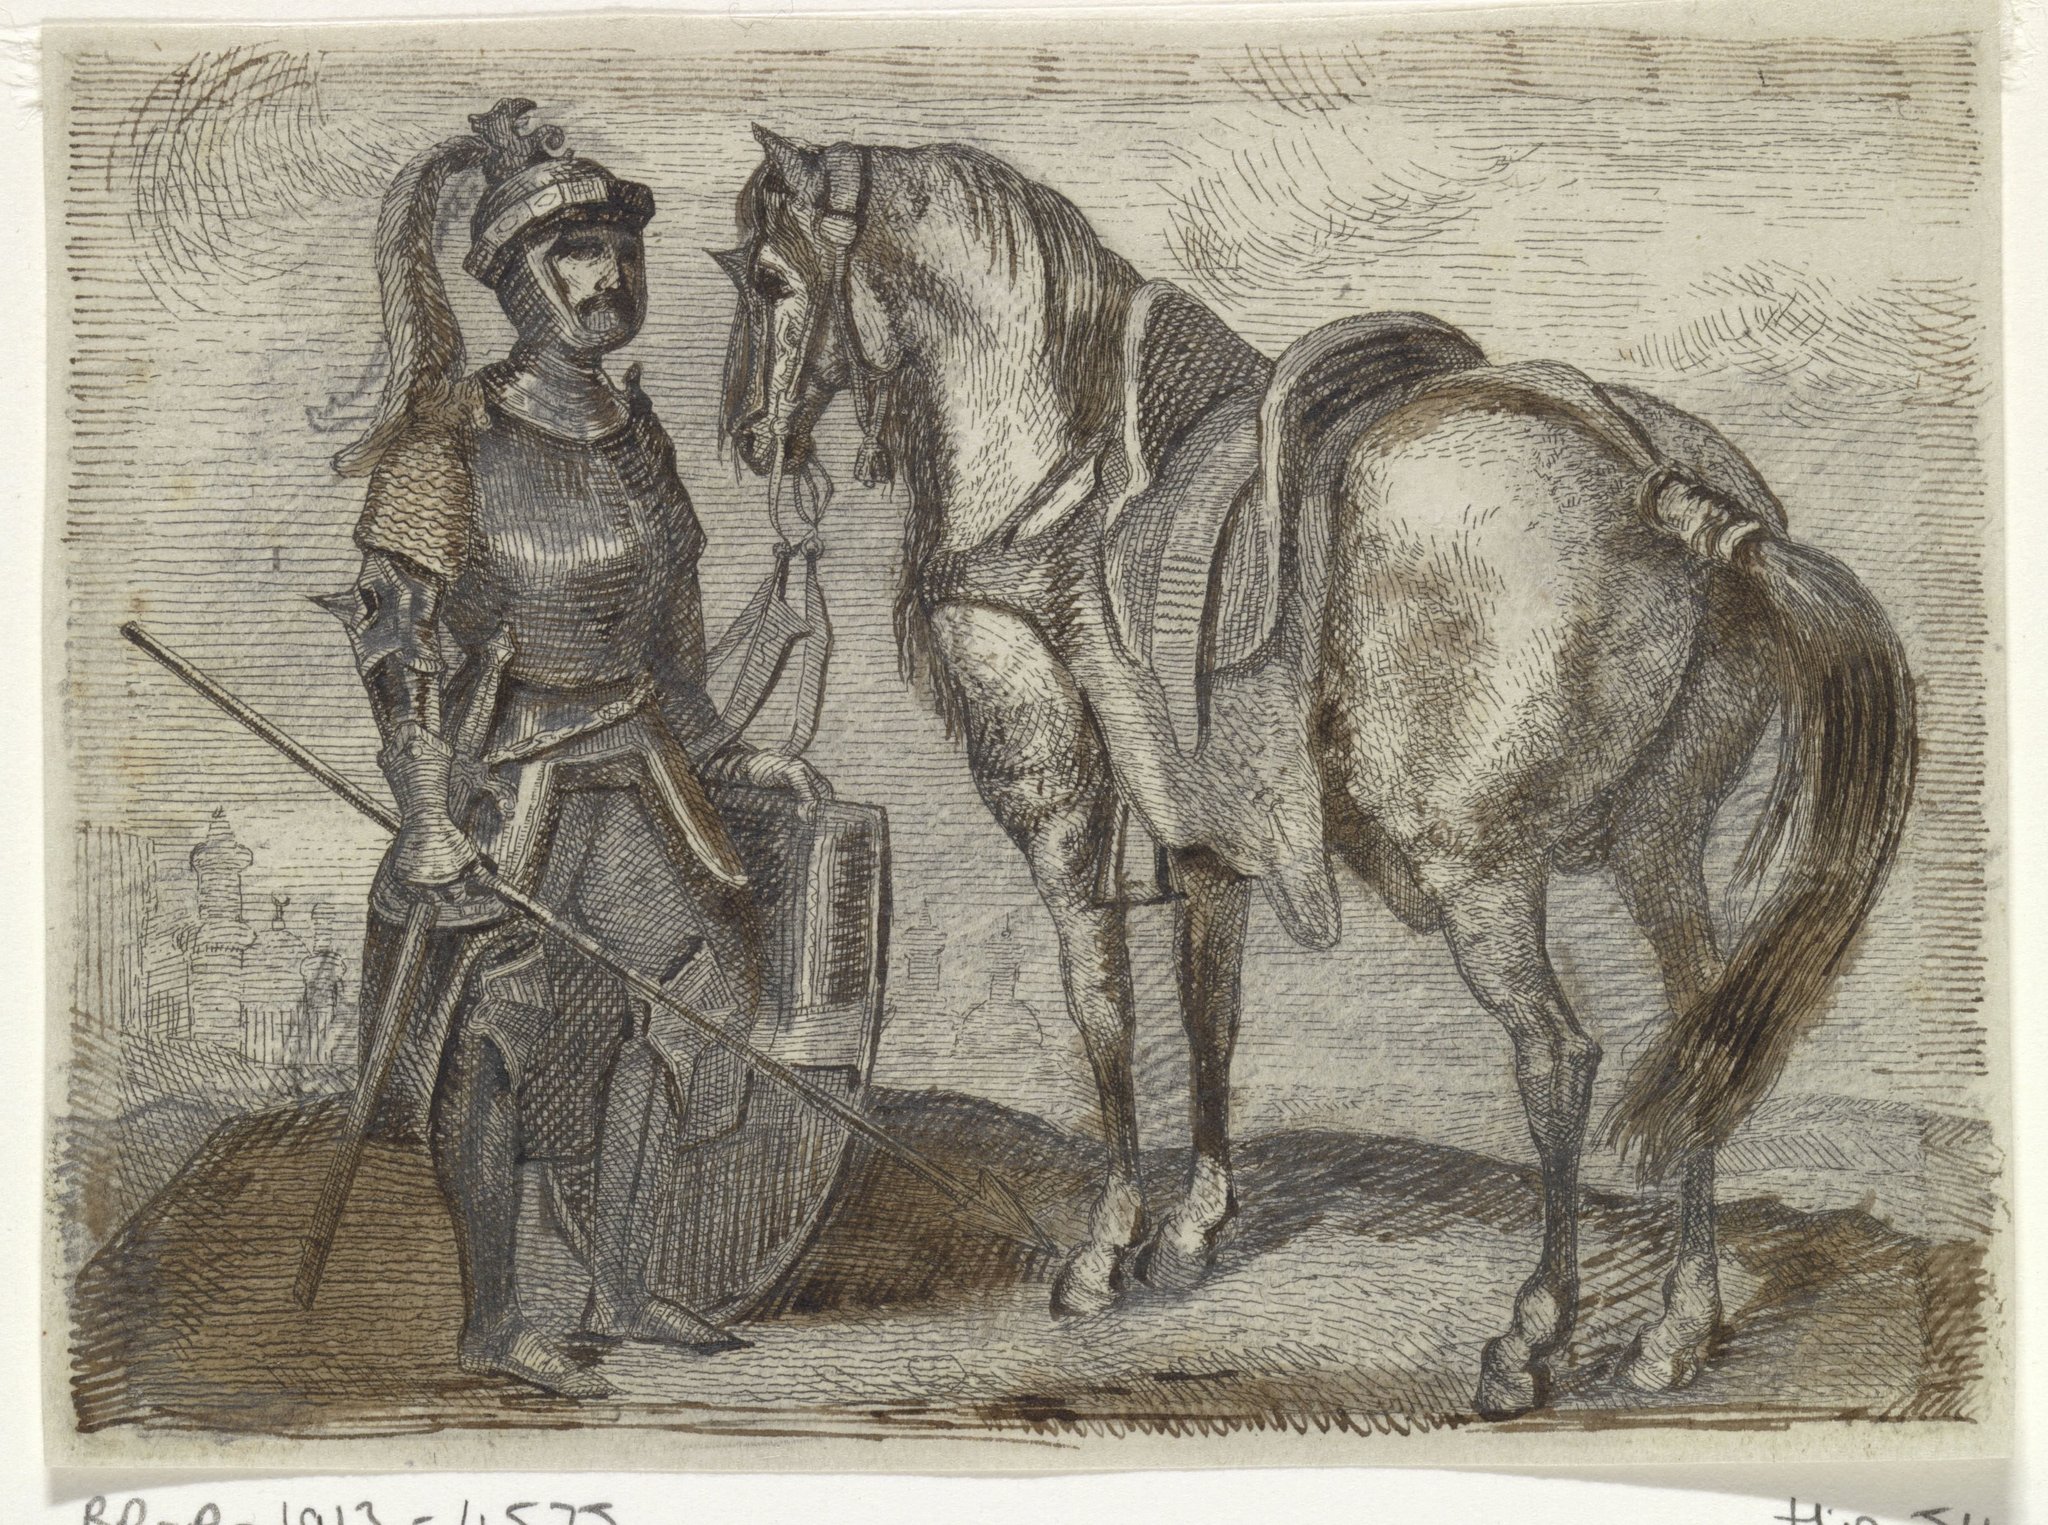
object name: print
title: Krijgsman en zijn paard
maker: arnoud schaepkens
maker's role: print maker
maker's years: 1816-1904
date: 1831-1904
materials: ink, paper, pencil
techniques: brush, etching, pen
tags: riding a horse, ass, or mule; rider, horseman, private soldier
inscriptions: collector's mark: Lugt 2228, collector's mark: Lugt 1485